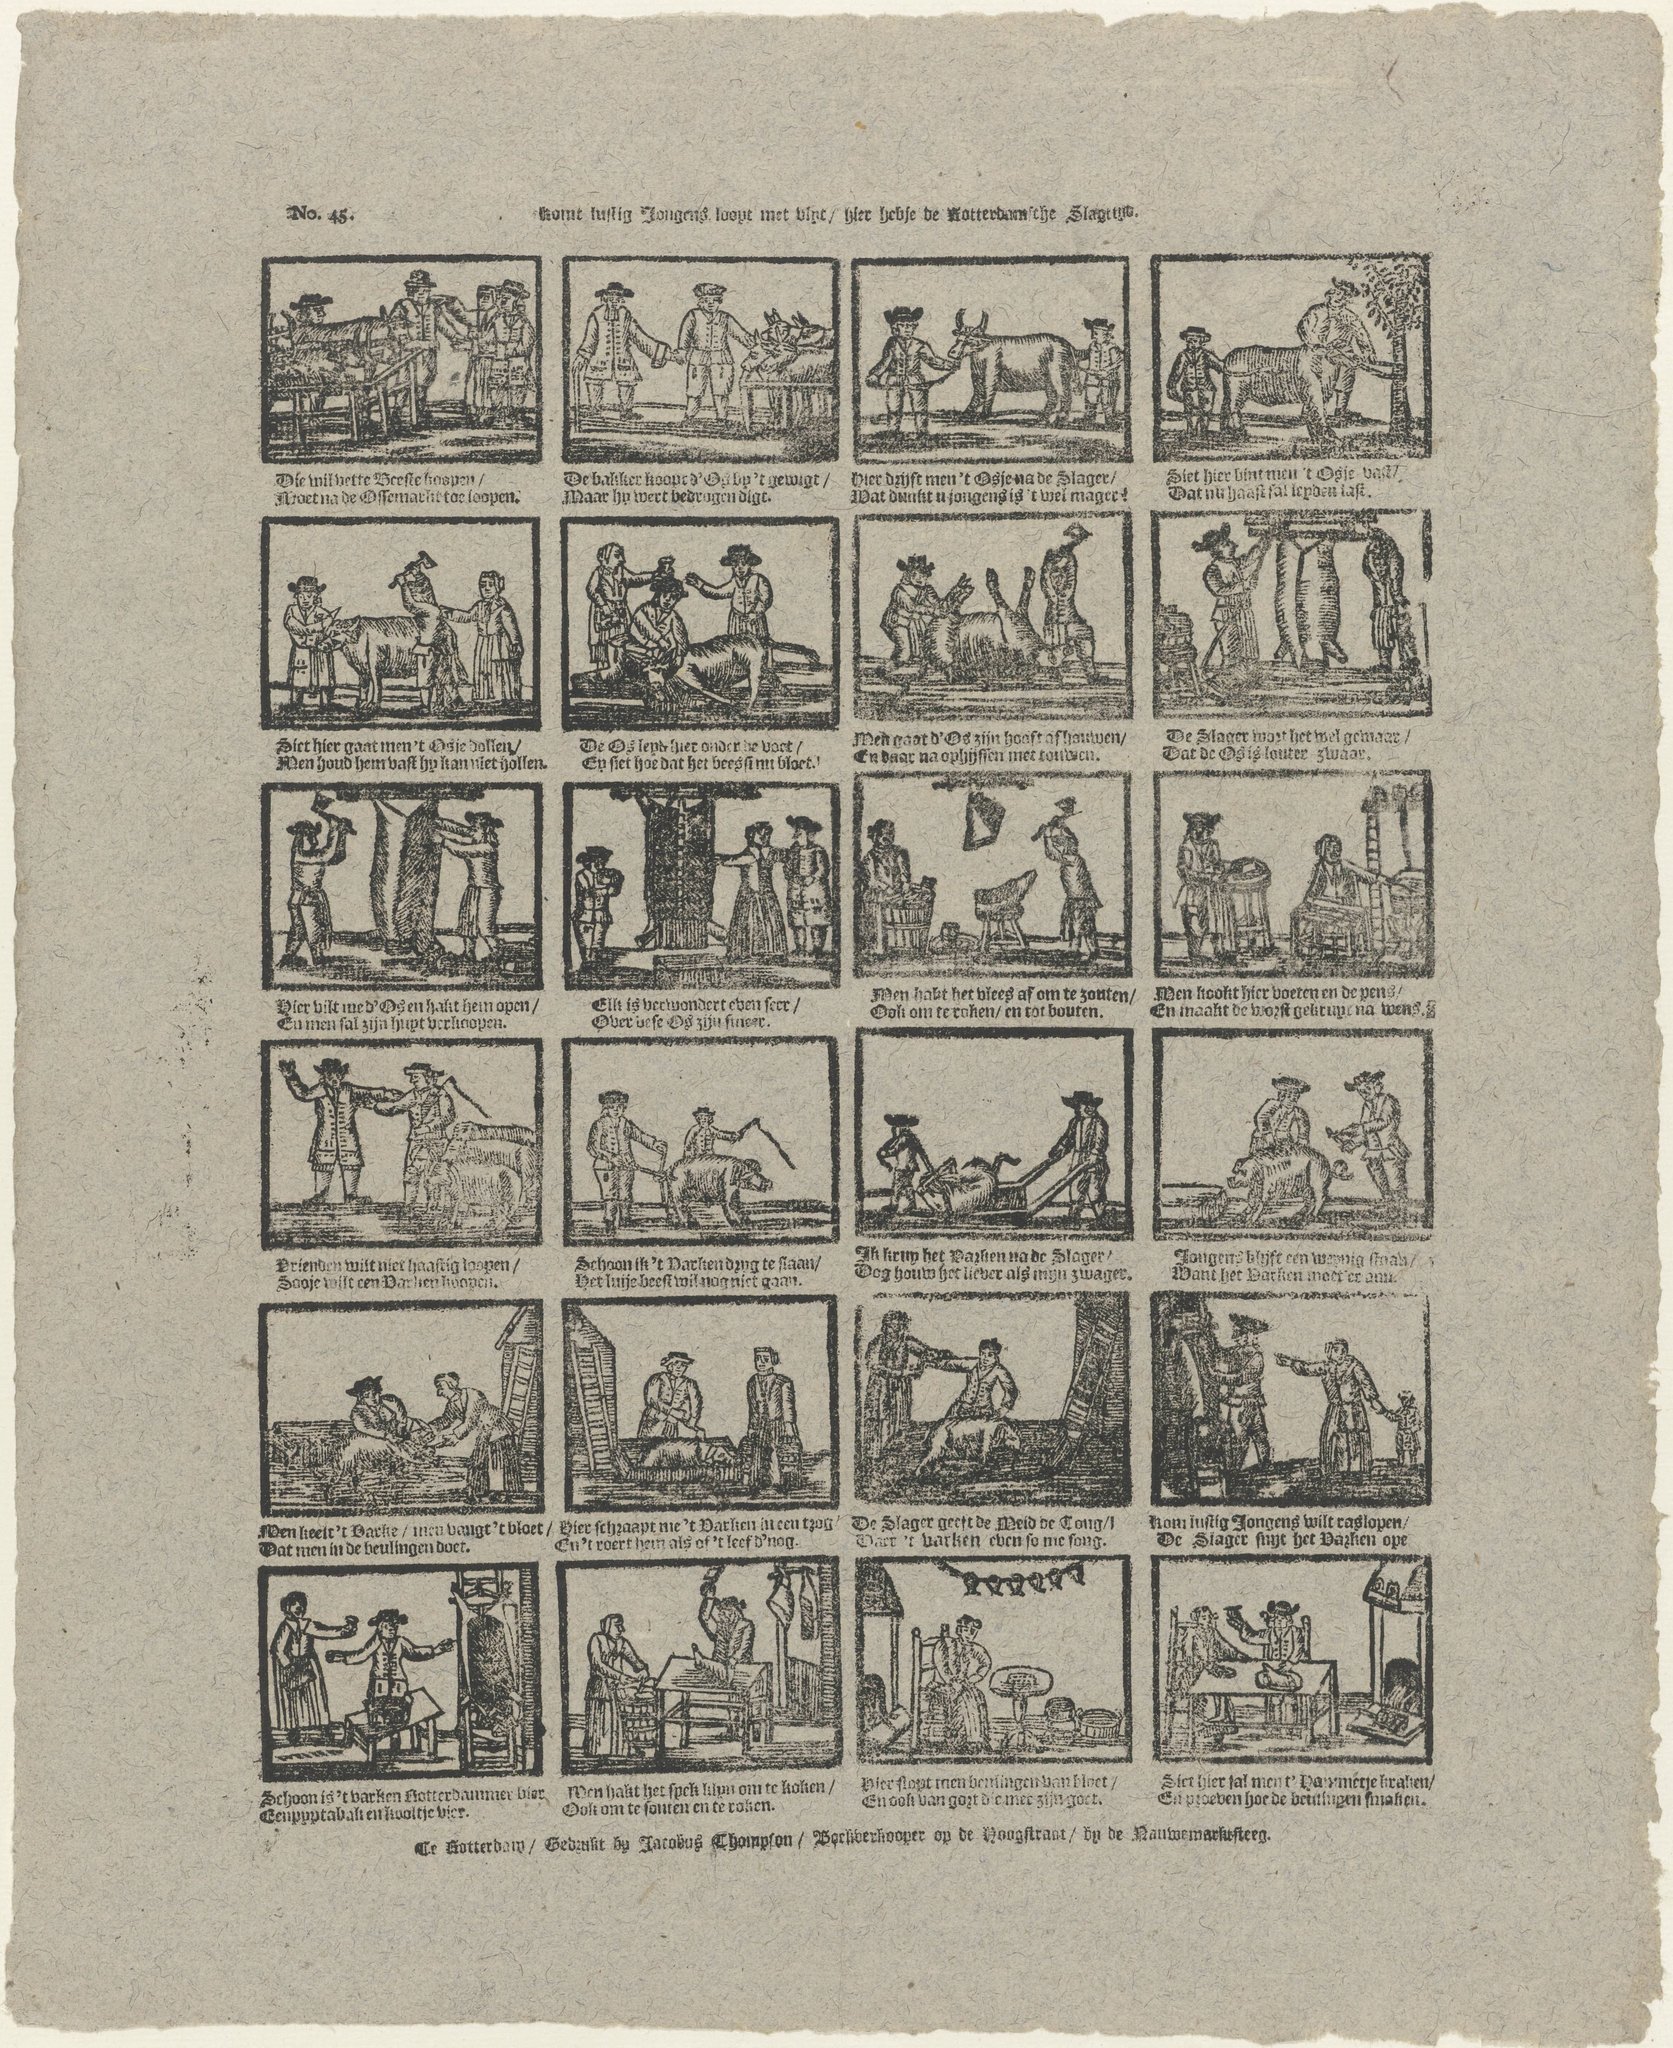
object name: popular print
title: Komt lustig jongens, loopt met vlijt / Hier hebje de Rotterdamsche slagttijd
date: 1791-1812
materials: paper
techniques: letterpress printing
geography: netherlands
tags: slaughtered ox or pig, butcher, slaughterman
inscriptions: collector's mark: Lugt 2760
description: Blad met 24 voorstellingen van het fokken, slachten en bereiden van koeien en varkens. Onder elke afbeelding een onderschrift. Genummerd linksboven: No. 45.